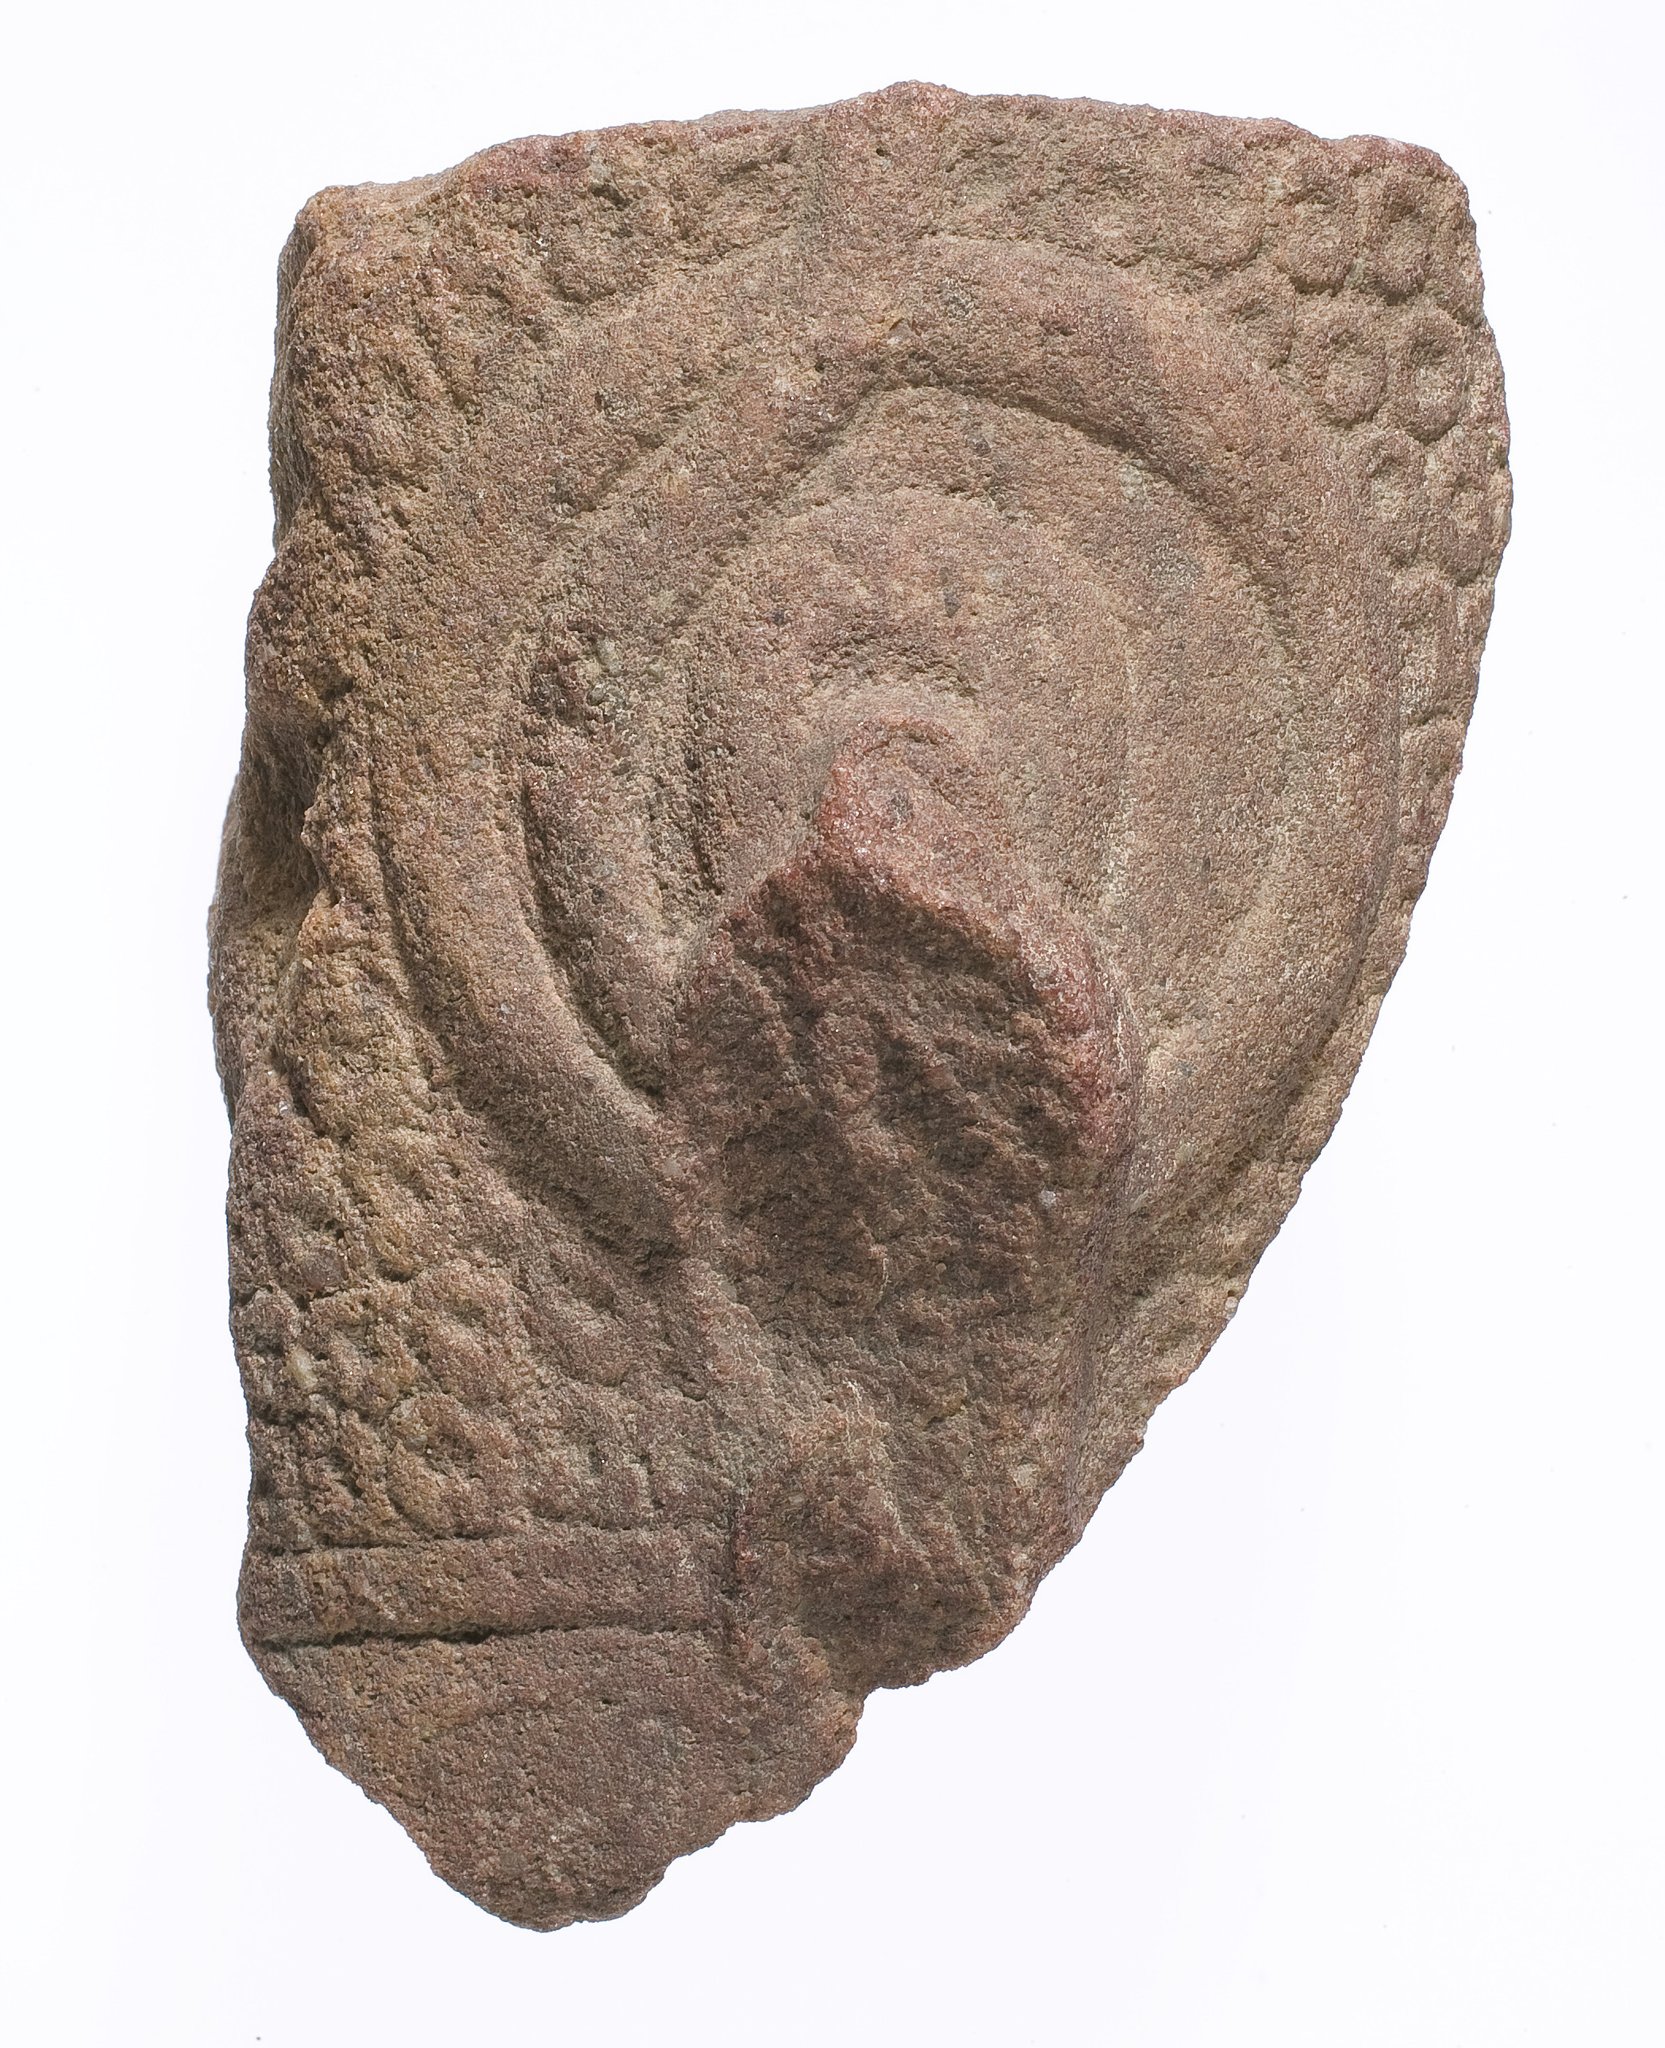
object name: crown with disc, uraeus coil, frontlet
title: Crown with discs, uraeus coils and frontlet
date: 1353-1336 BCE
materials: quartzite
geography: egypt